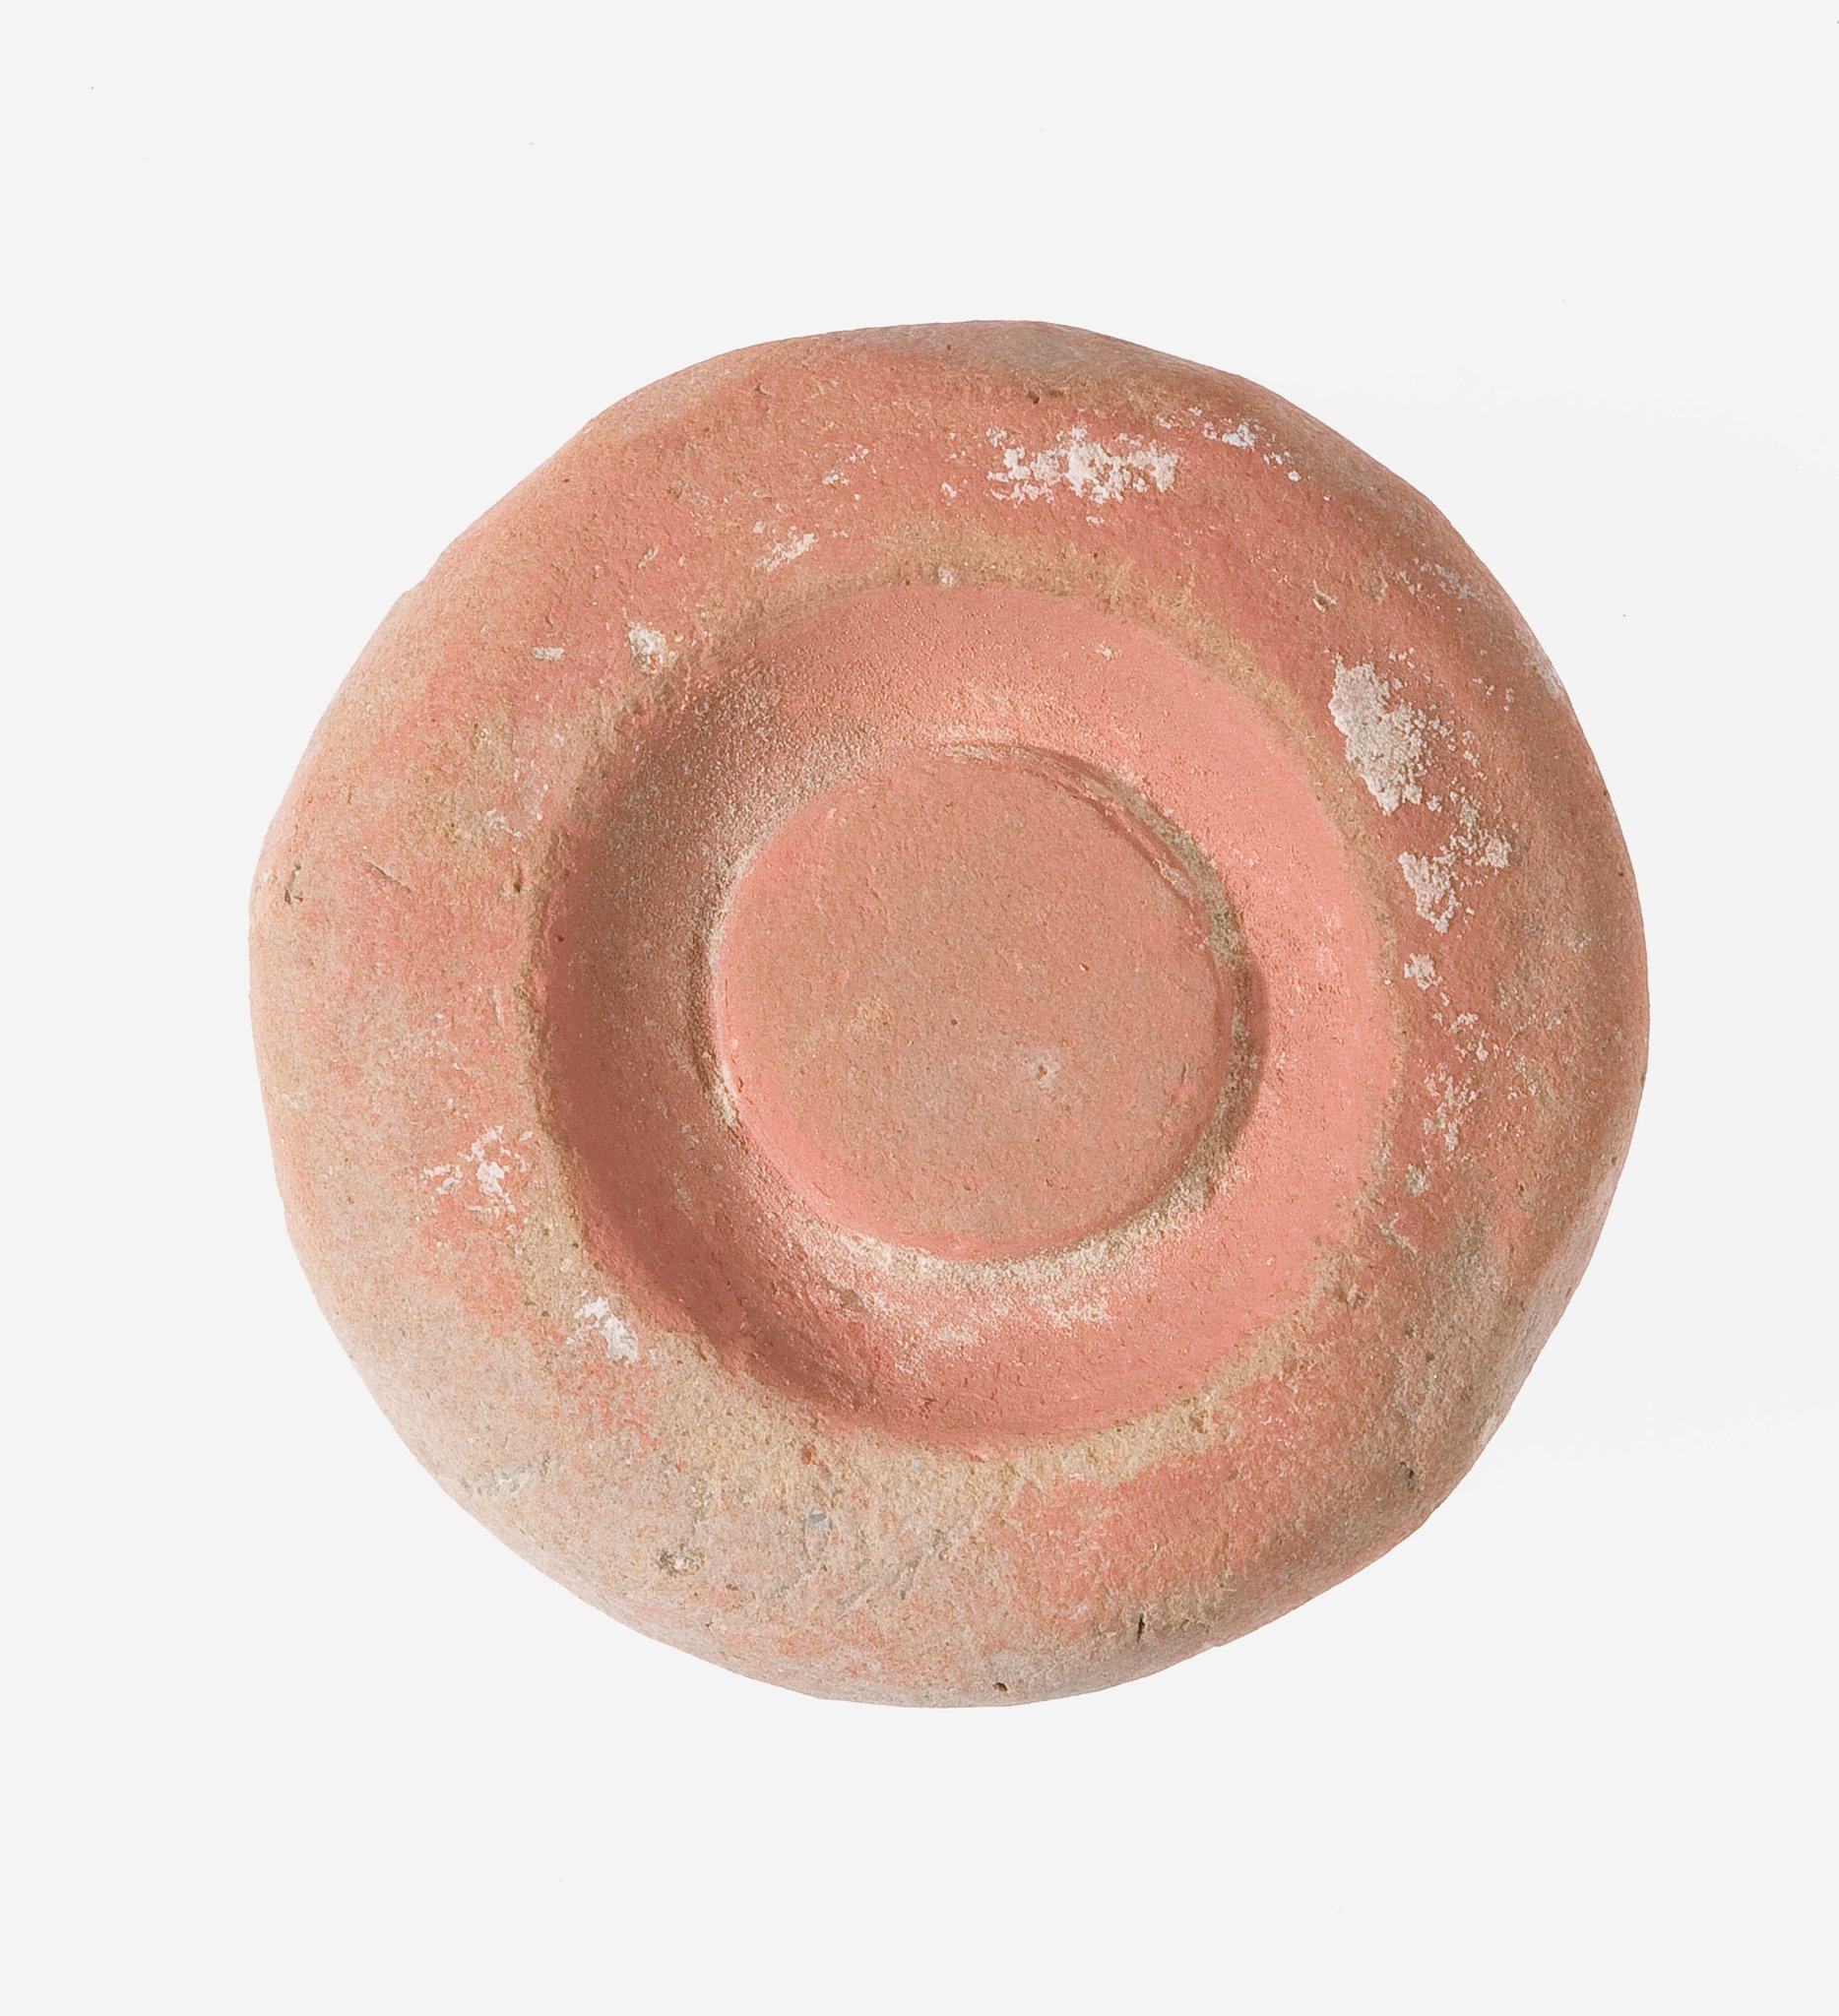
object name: mold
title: Mold for Annular Rings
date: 1390-1352 BCE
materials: pottery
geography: egypt